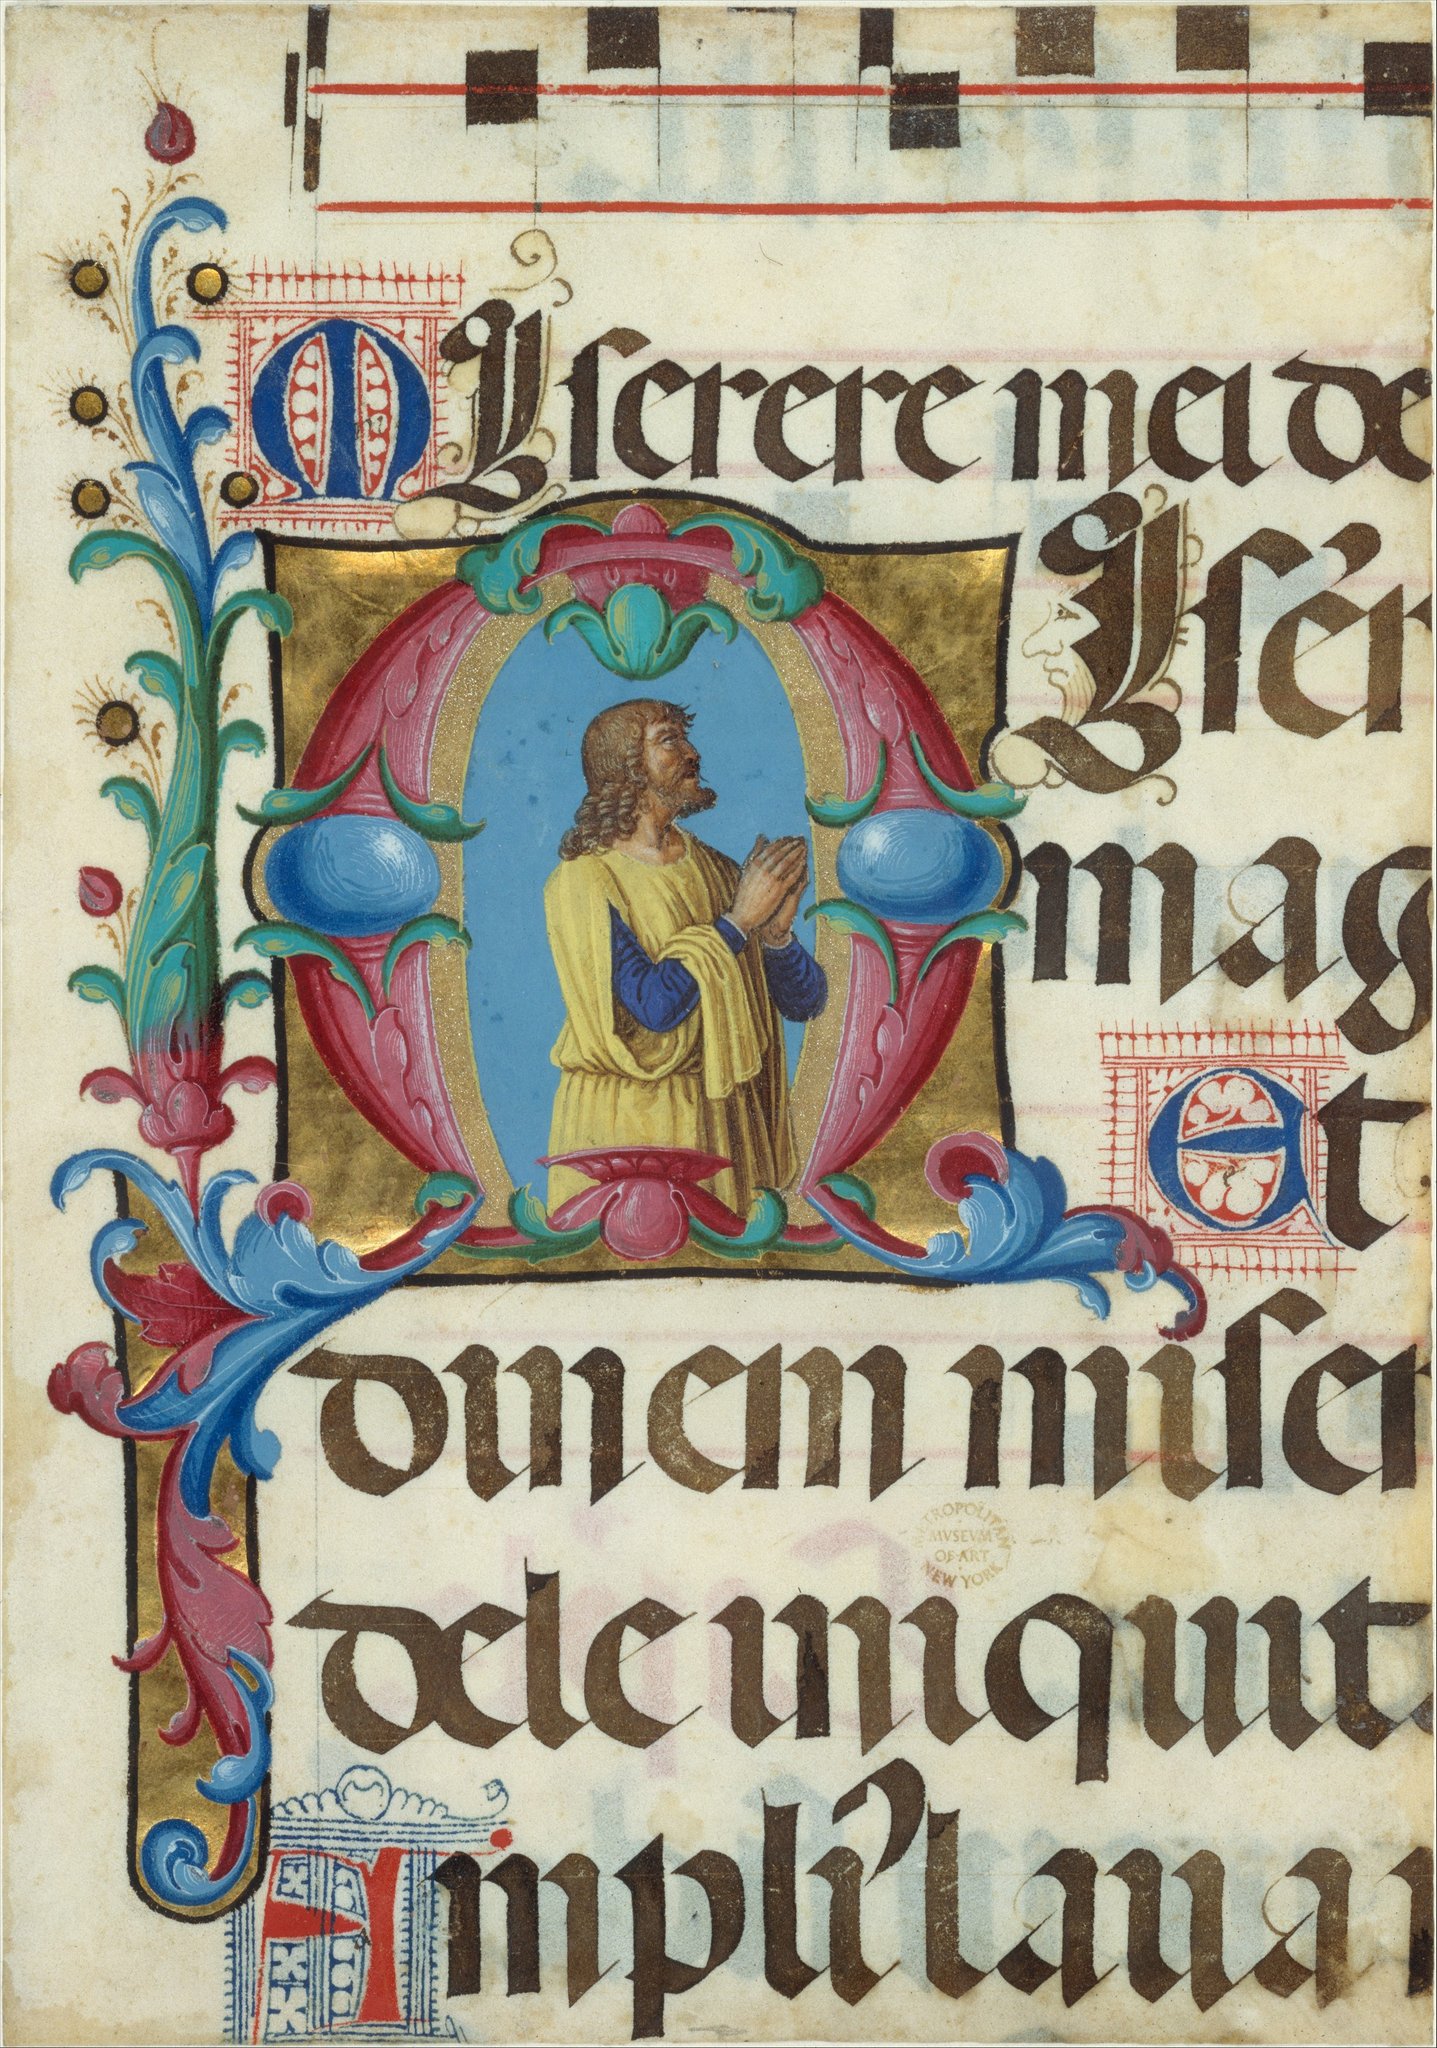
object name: psalter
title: Manuscript Illumination with David in Prayer in an Initial M, from a Psalter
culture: italian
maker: girolamo dai libri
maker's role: artist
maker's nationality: italian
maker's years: 1474-1555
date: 1501-1502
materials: gold, ink, parchment, paint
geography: italy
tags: david,praying